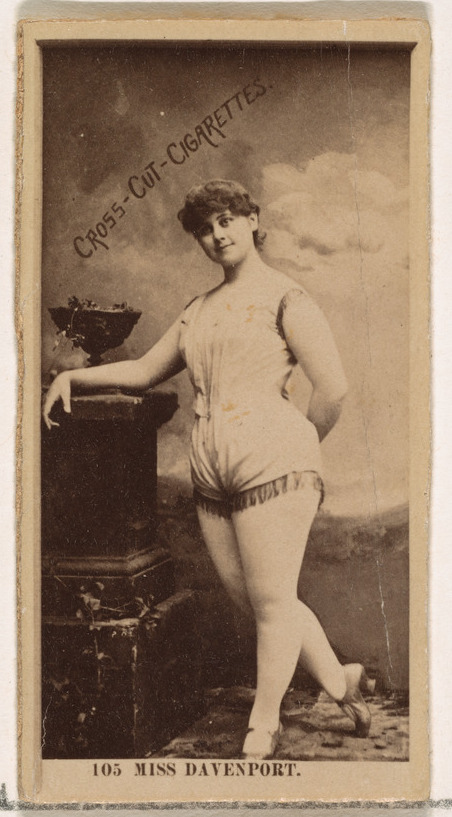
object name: print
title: Card Number 105, Fanny Davenport, from the Actors and Actresses series (N145-2) issued by Duke Sons & Co. to promote Cross Cut Cigarettes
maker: w. duke, sons & co.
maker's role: publisher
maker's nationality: american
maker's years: 1870-1920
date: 1880-1889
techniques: albumen silver print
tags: portraits,women,actresses